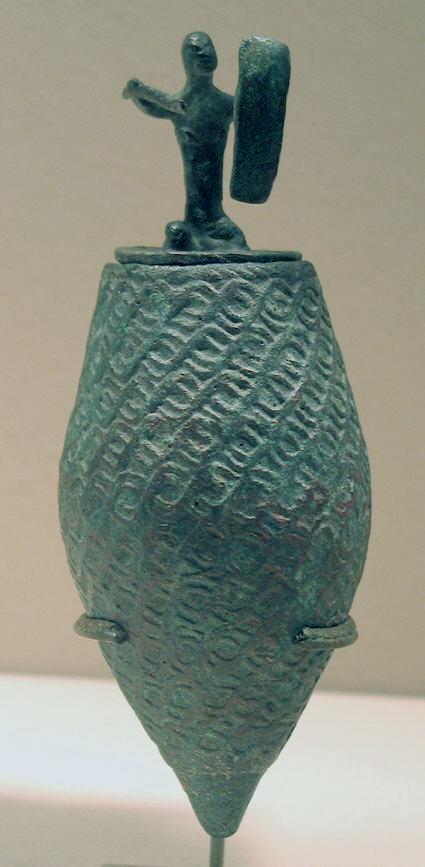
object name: lime container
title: Lime Container Topped by a Warrior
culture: indonesian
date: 500 BCE-300 CE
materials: bronze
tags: human figures